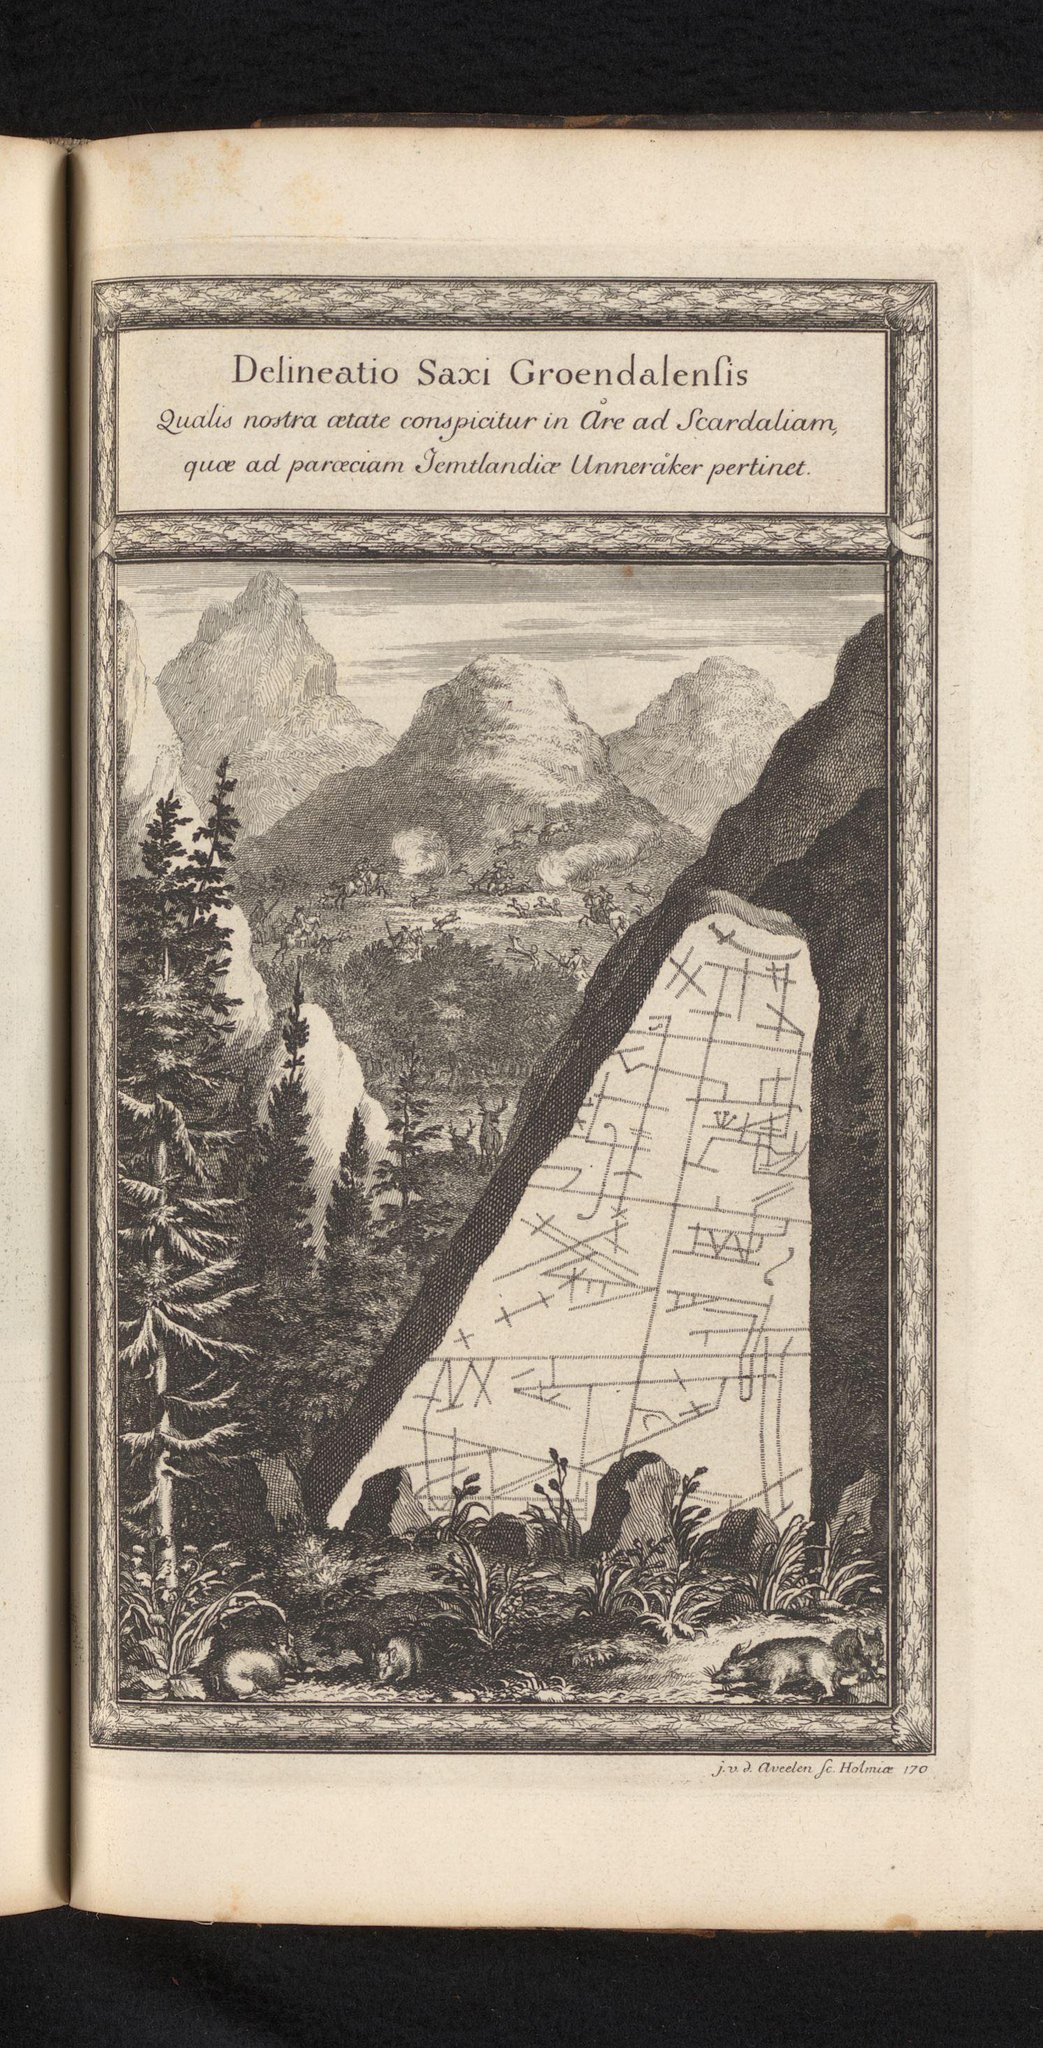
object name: print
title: Delineatio Saxi Groendalensis Qualis nostra ætate conspicitur in Åre ad Scardaliam, quae ad paraeciam Jemtlandiæ Unneråker pertinet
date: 1701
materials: paper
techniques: etching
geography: stockholm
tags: grönan valei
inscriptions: date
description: Kungliga Biblioteket, 'Suecia': http://www.kb.se/samlingarna/Kartor-bilder/Suecia-antiqua/ (geraadpleegd november 2016).